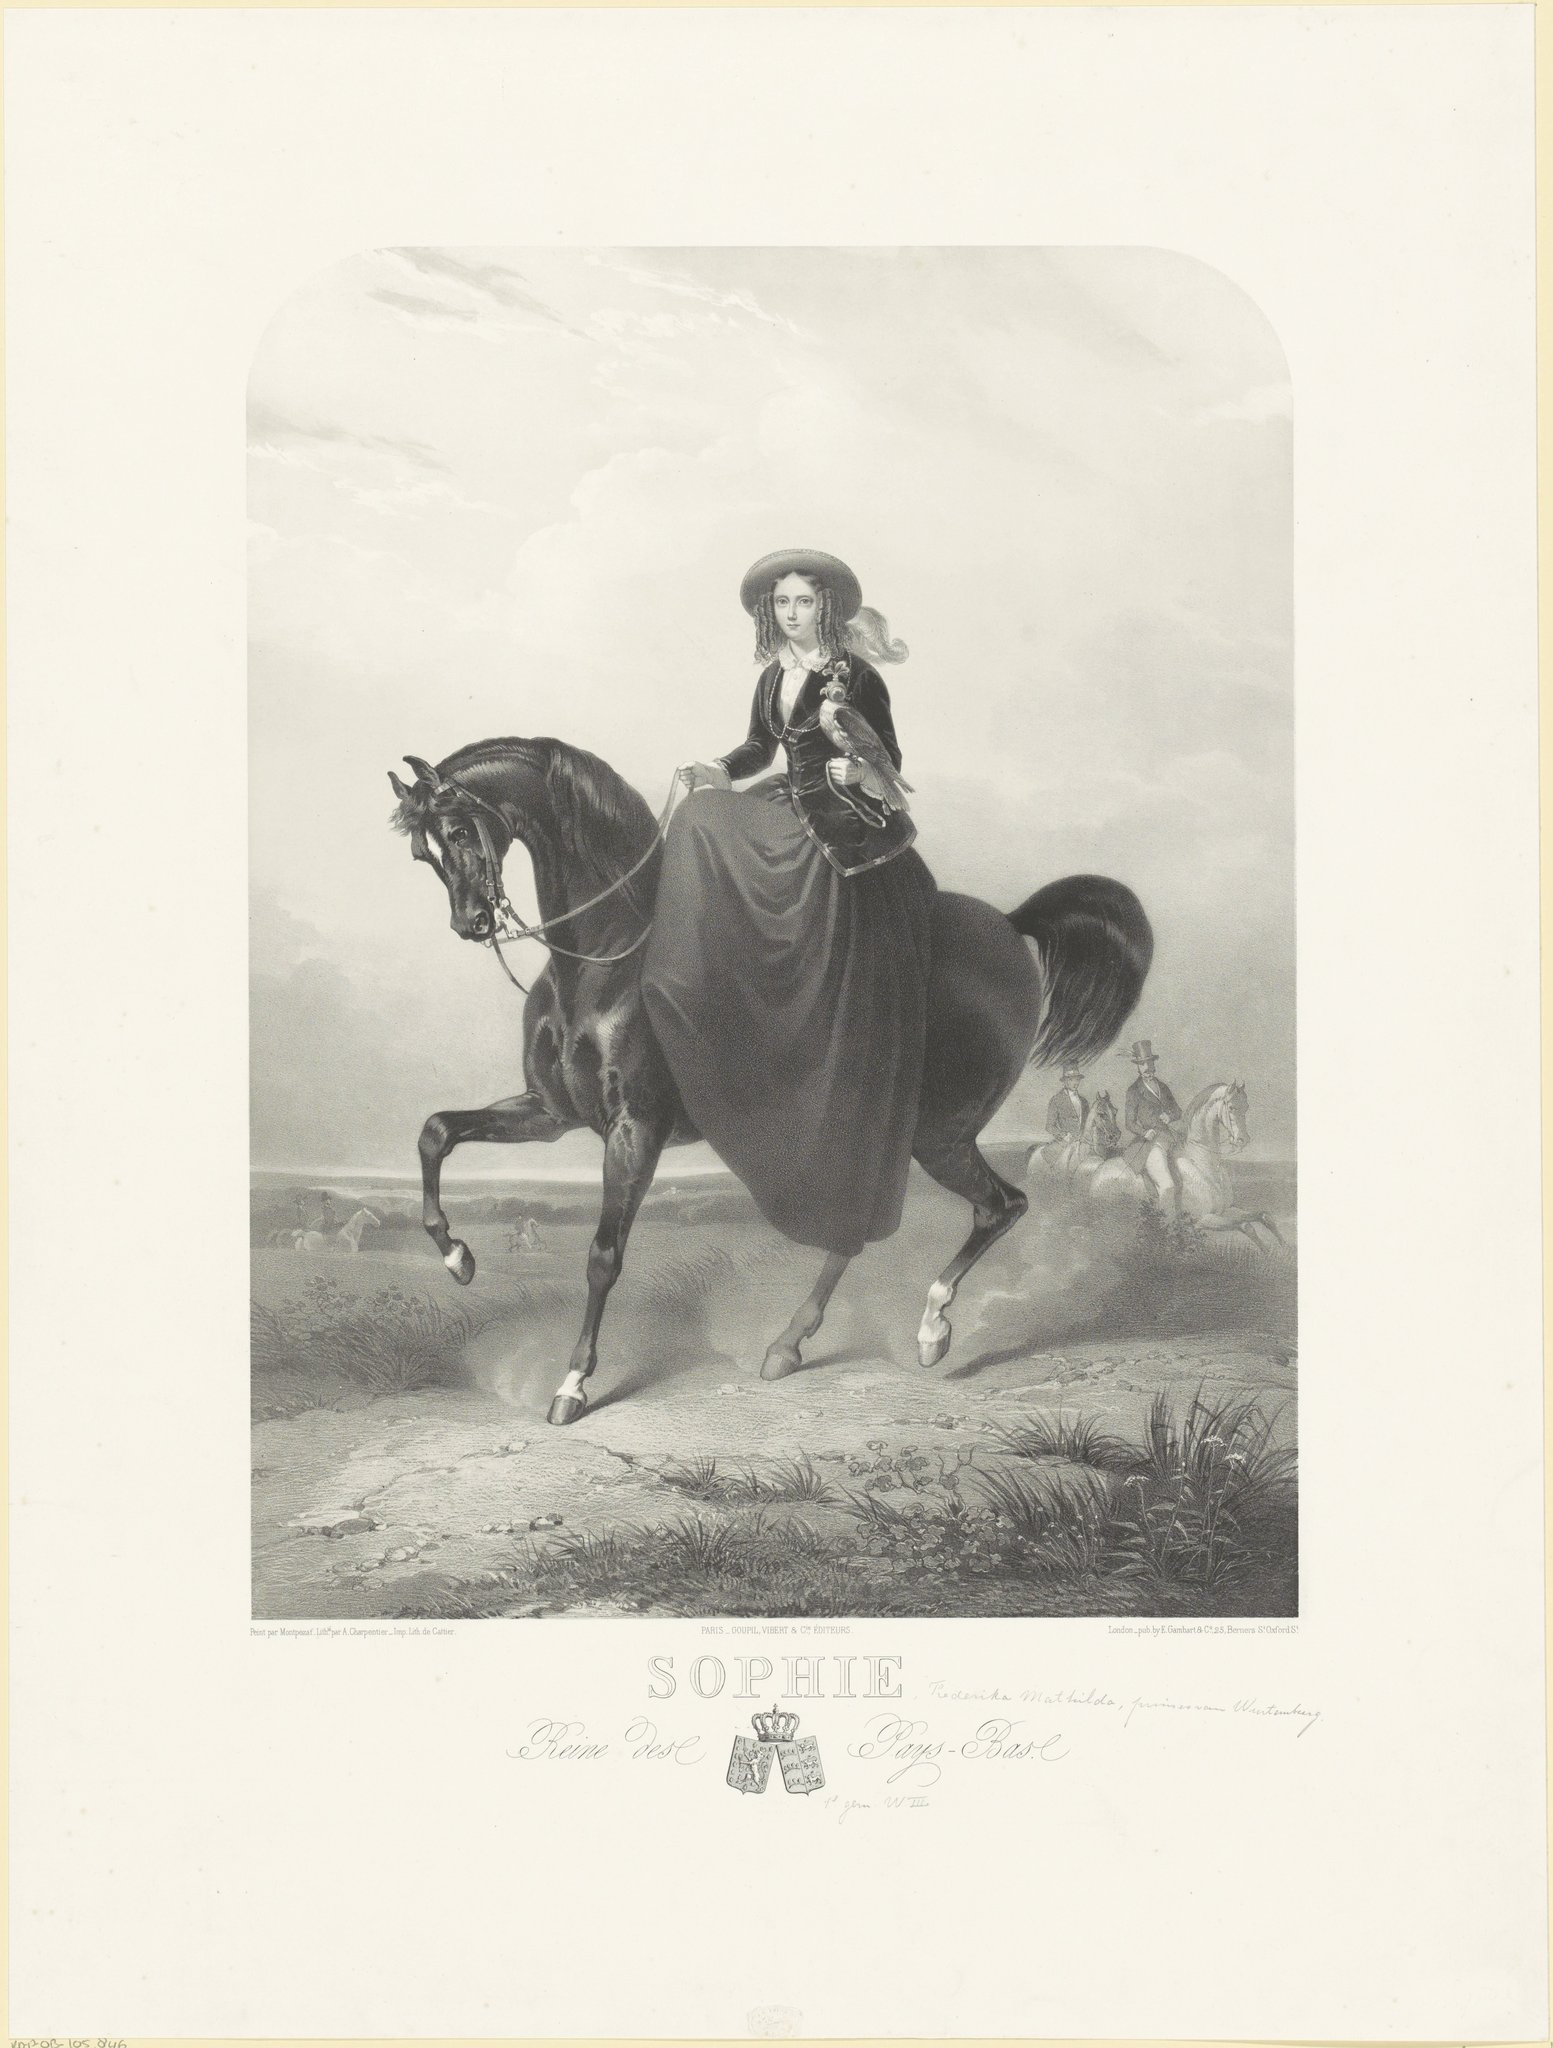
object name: print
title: Ruiterportret van Sophie van Württemberg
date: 1849-1871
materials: paper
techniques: lithograph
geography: paris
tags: the hague, sophia frederika mathilda van württemberg, predatory birds: falcon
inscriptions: collector's mark: Lugt 963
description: Ruiterportret van Sophie. Op haar linkerhand een valk. Midden onder twee wapens met een kroon. In de ondermarge haar naam en titel.